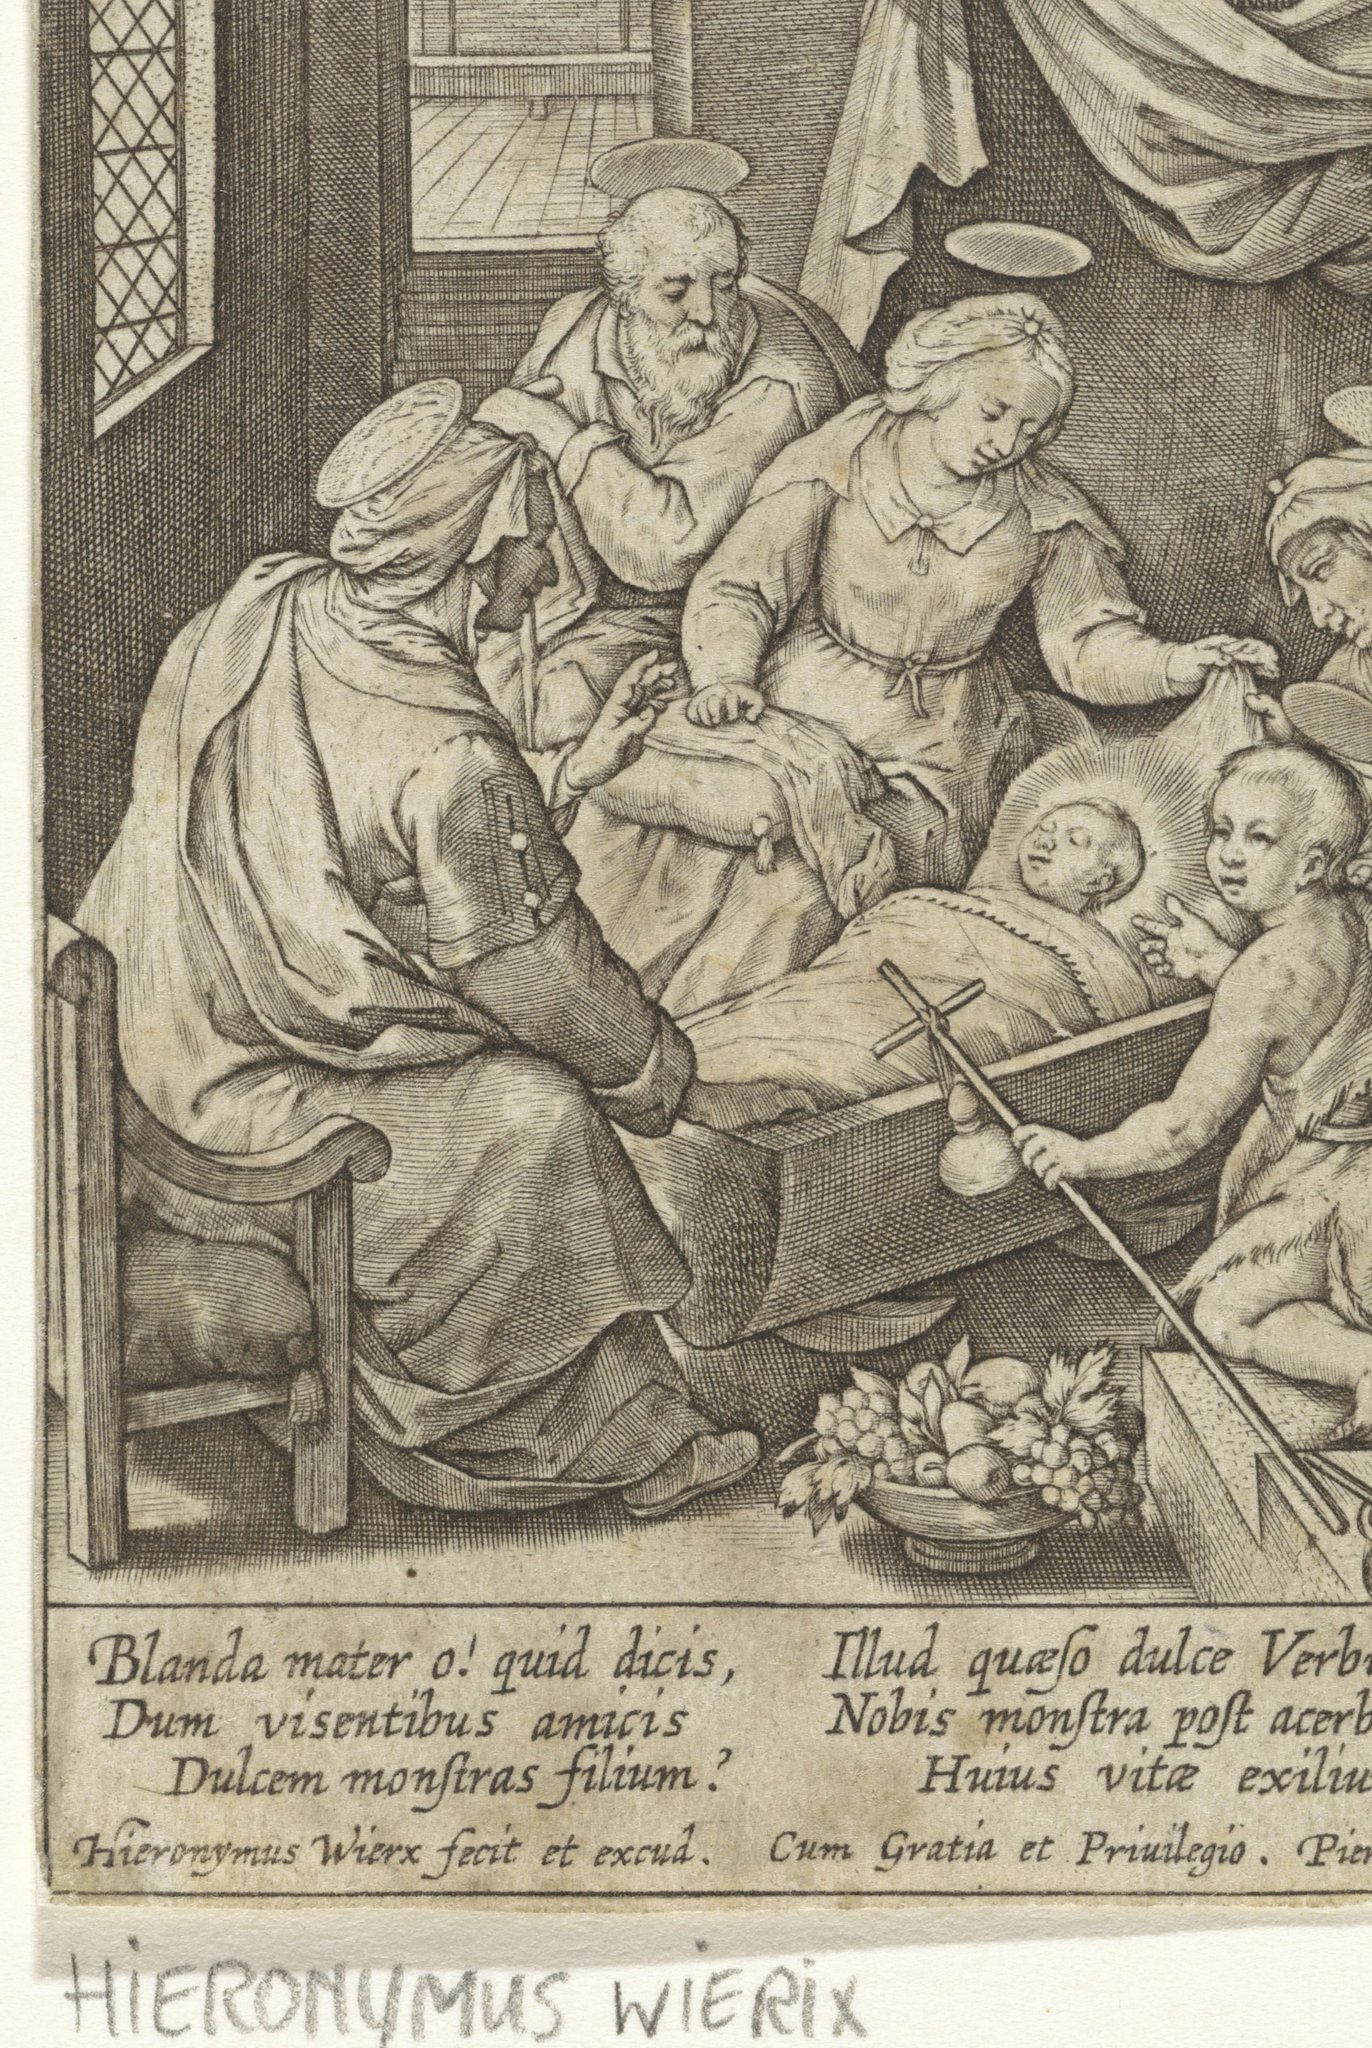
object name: print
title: Christuskind slaapt in de wieg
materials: paper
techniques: engraving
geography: antwerp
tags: single instruments of the passion, anna, mother of mary; possible attributes: book, christ-child, lily, virgin mary, holy family with john the baptist, elisabeth present, cradle, crib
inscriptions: collector's mark: Lugt 2228, inscription: ‘Fragment van een tekst, veertien regels zichtbaar.’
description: Het Christuskind slaapt vredig in zijn wieg. Maria, Jozef, Anna, de jonge Johannes de Doper en Elisabet zitten rond zijn wieg. Op de voorgrond een mand met fruit. In de marge een zesregelig onderschrift, in twee kolommen, in het Latijn. Rechtsboven gemerkt: fol. 317.